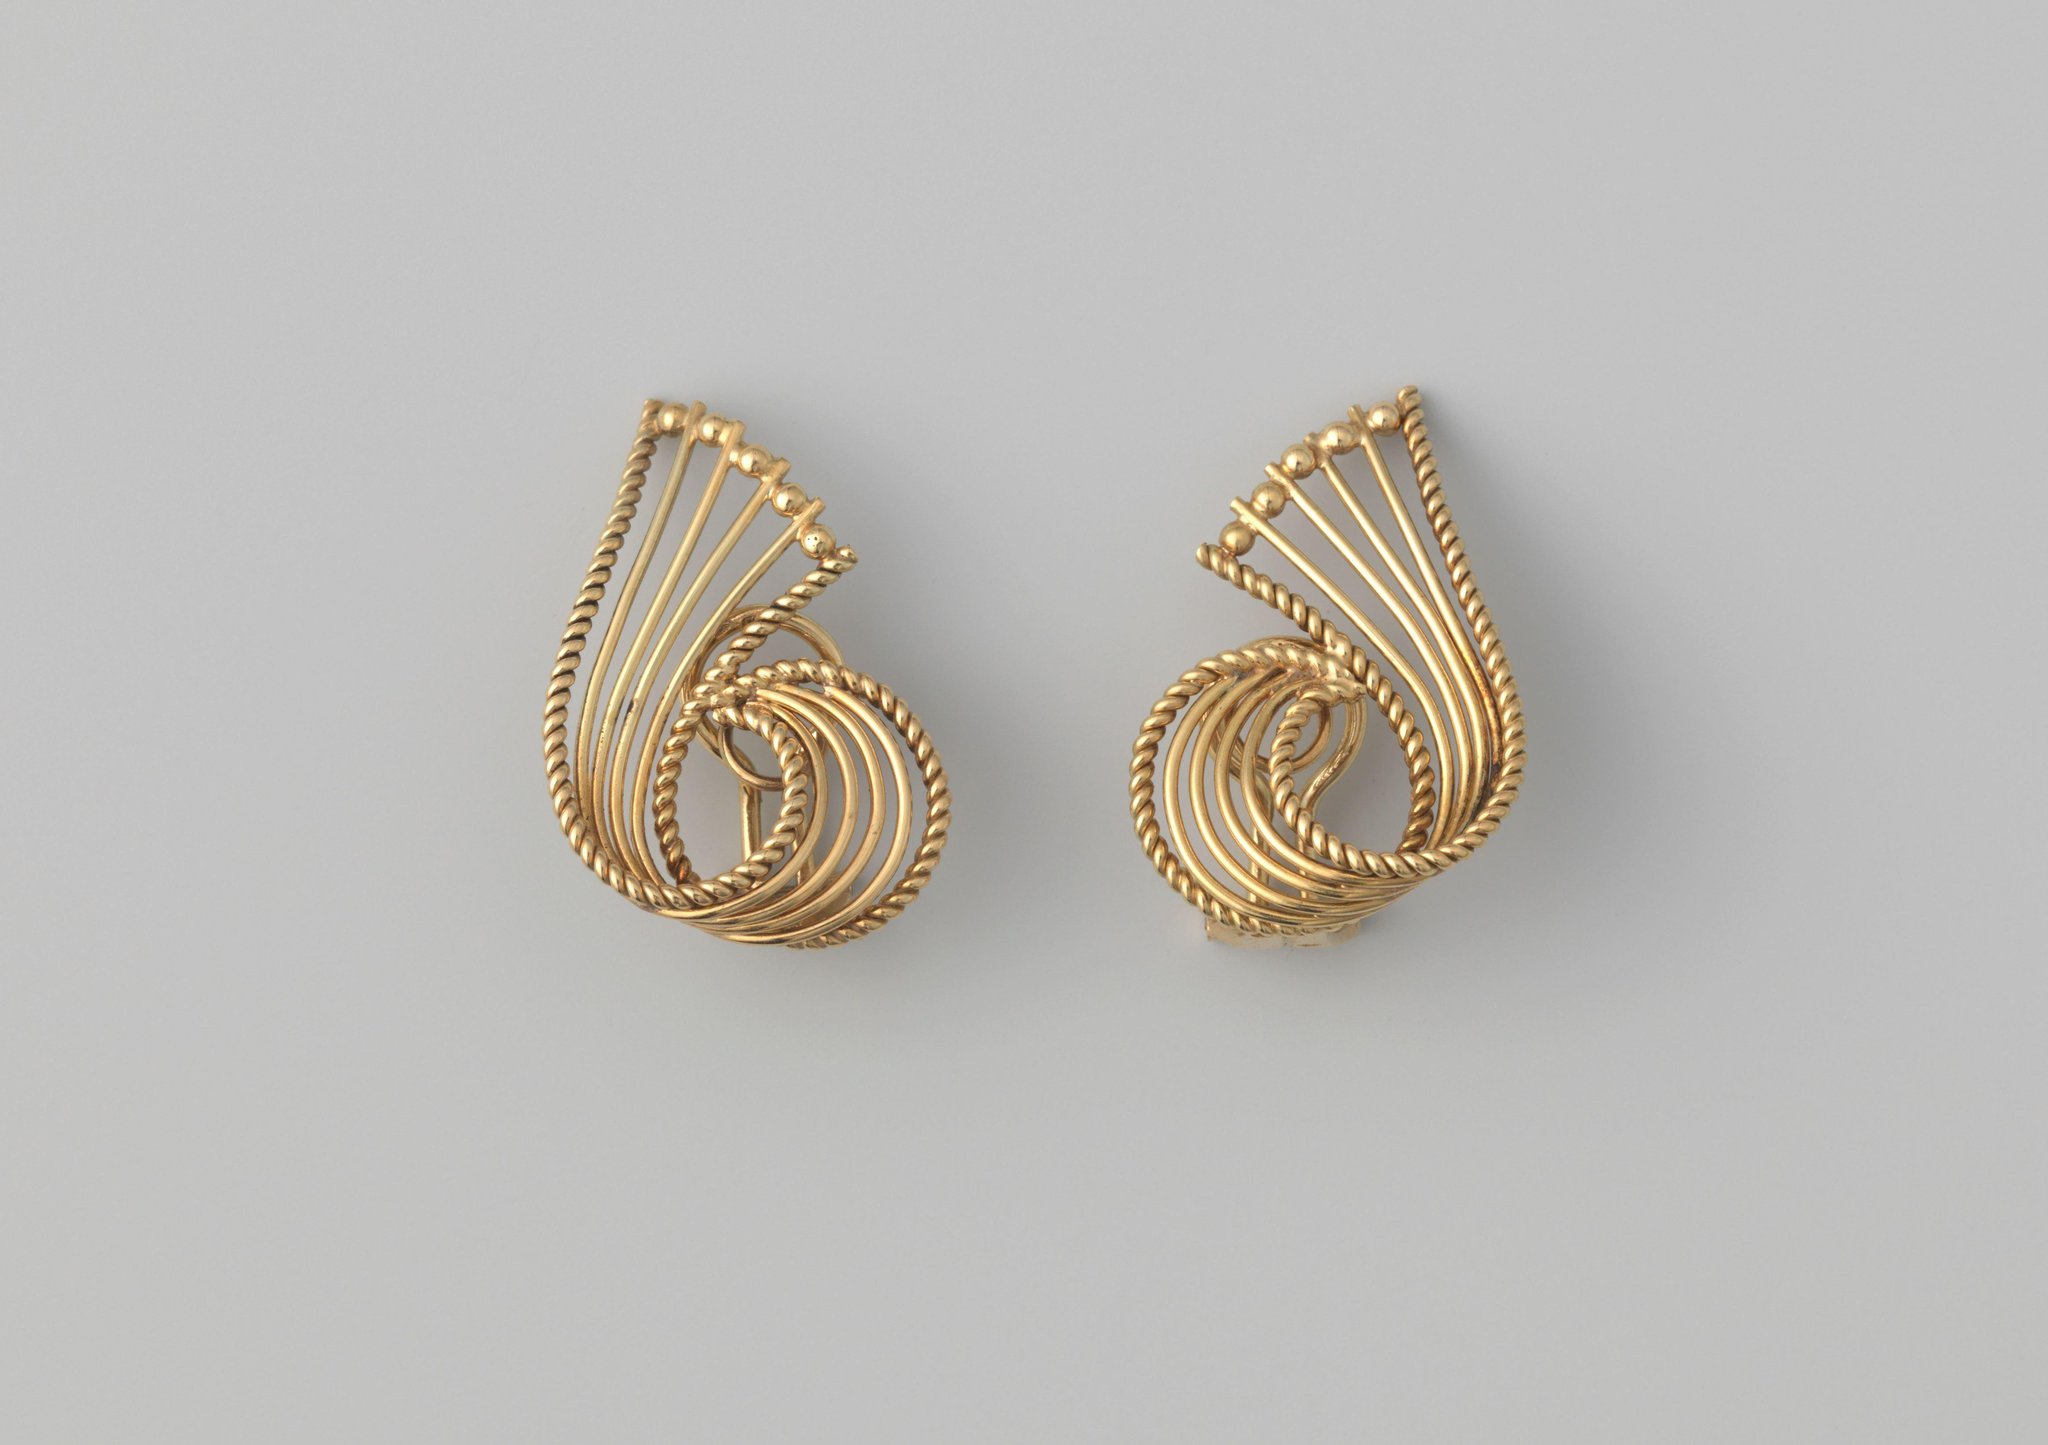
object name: earring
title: Oorclip van gouddraad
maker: jan hessing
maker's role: juwelier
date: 1957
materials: gold thread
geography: voorburg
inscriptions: maker's mark: ‘HI? HD?’, alloy mark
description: Oorclip van gouddraad. De binnenste draden van het krullend model zijn glad de draden aan de buitenkant zijn opgebouwd uit bollen.